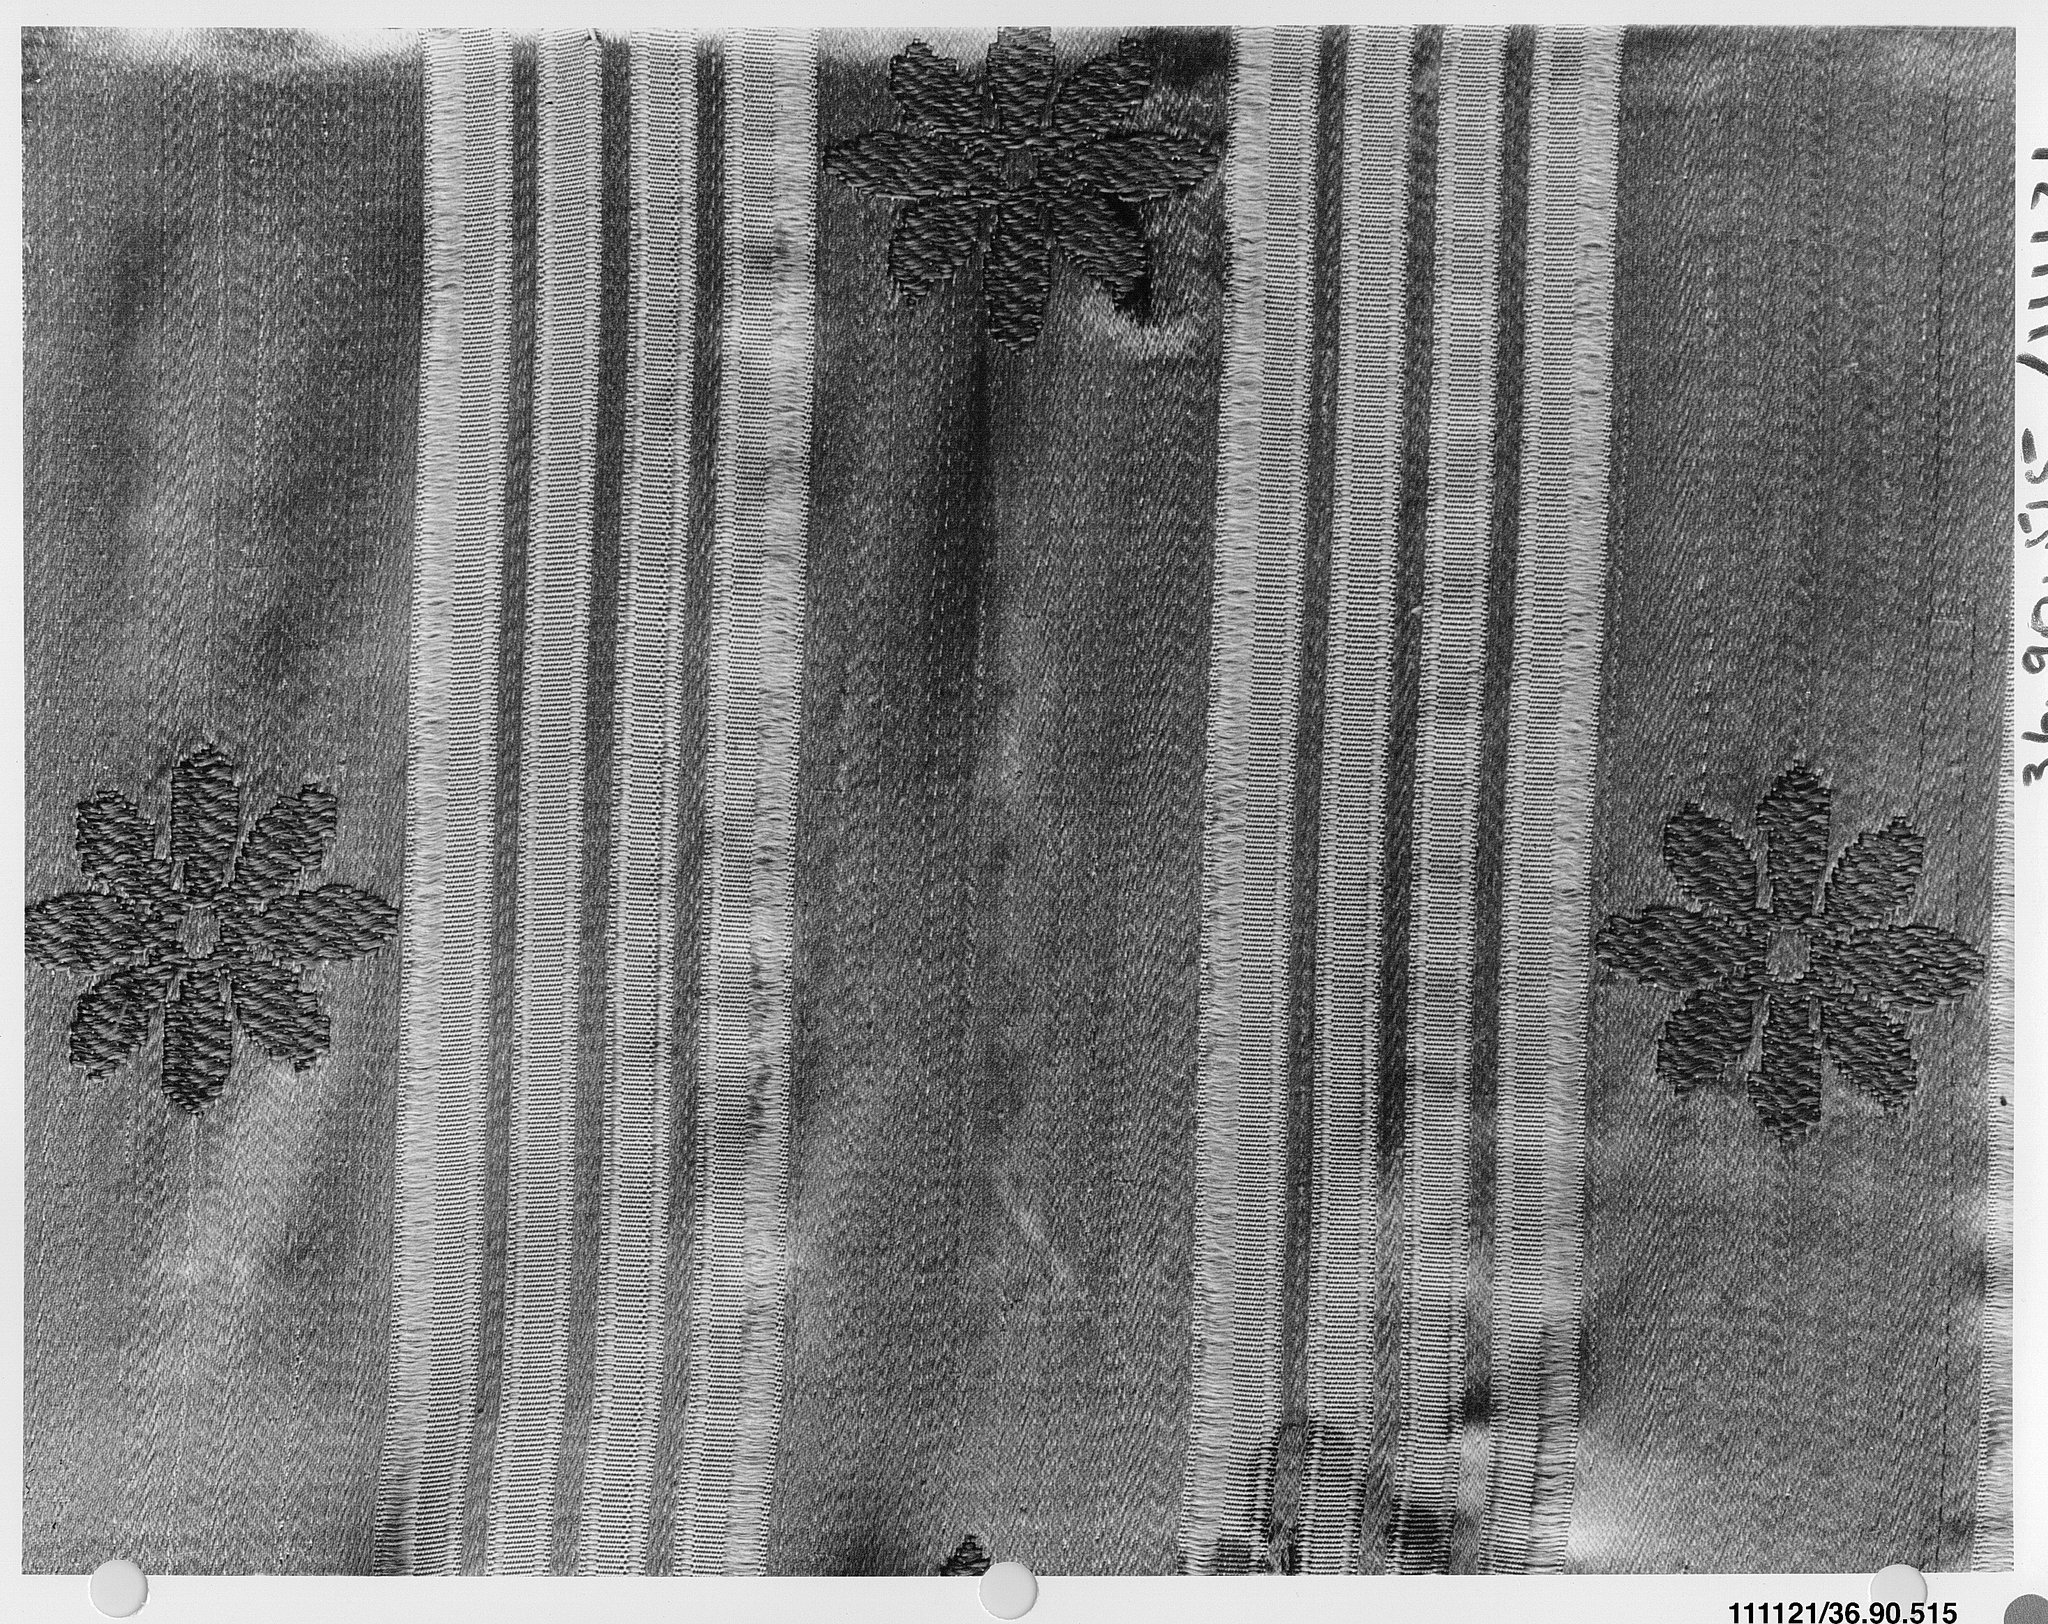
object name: piece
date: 1801-1833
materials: silk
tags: flowers